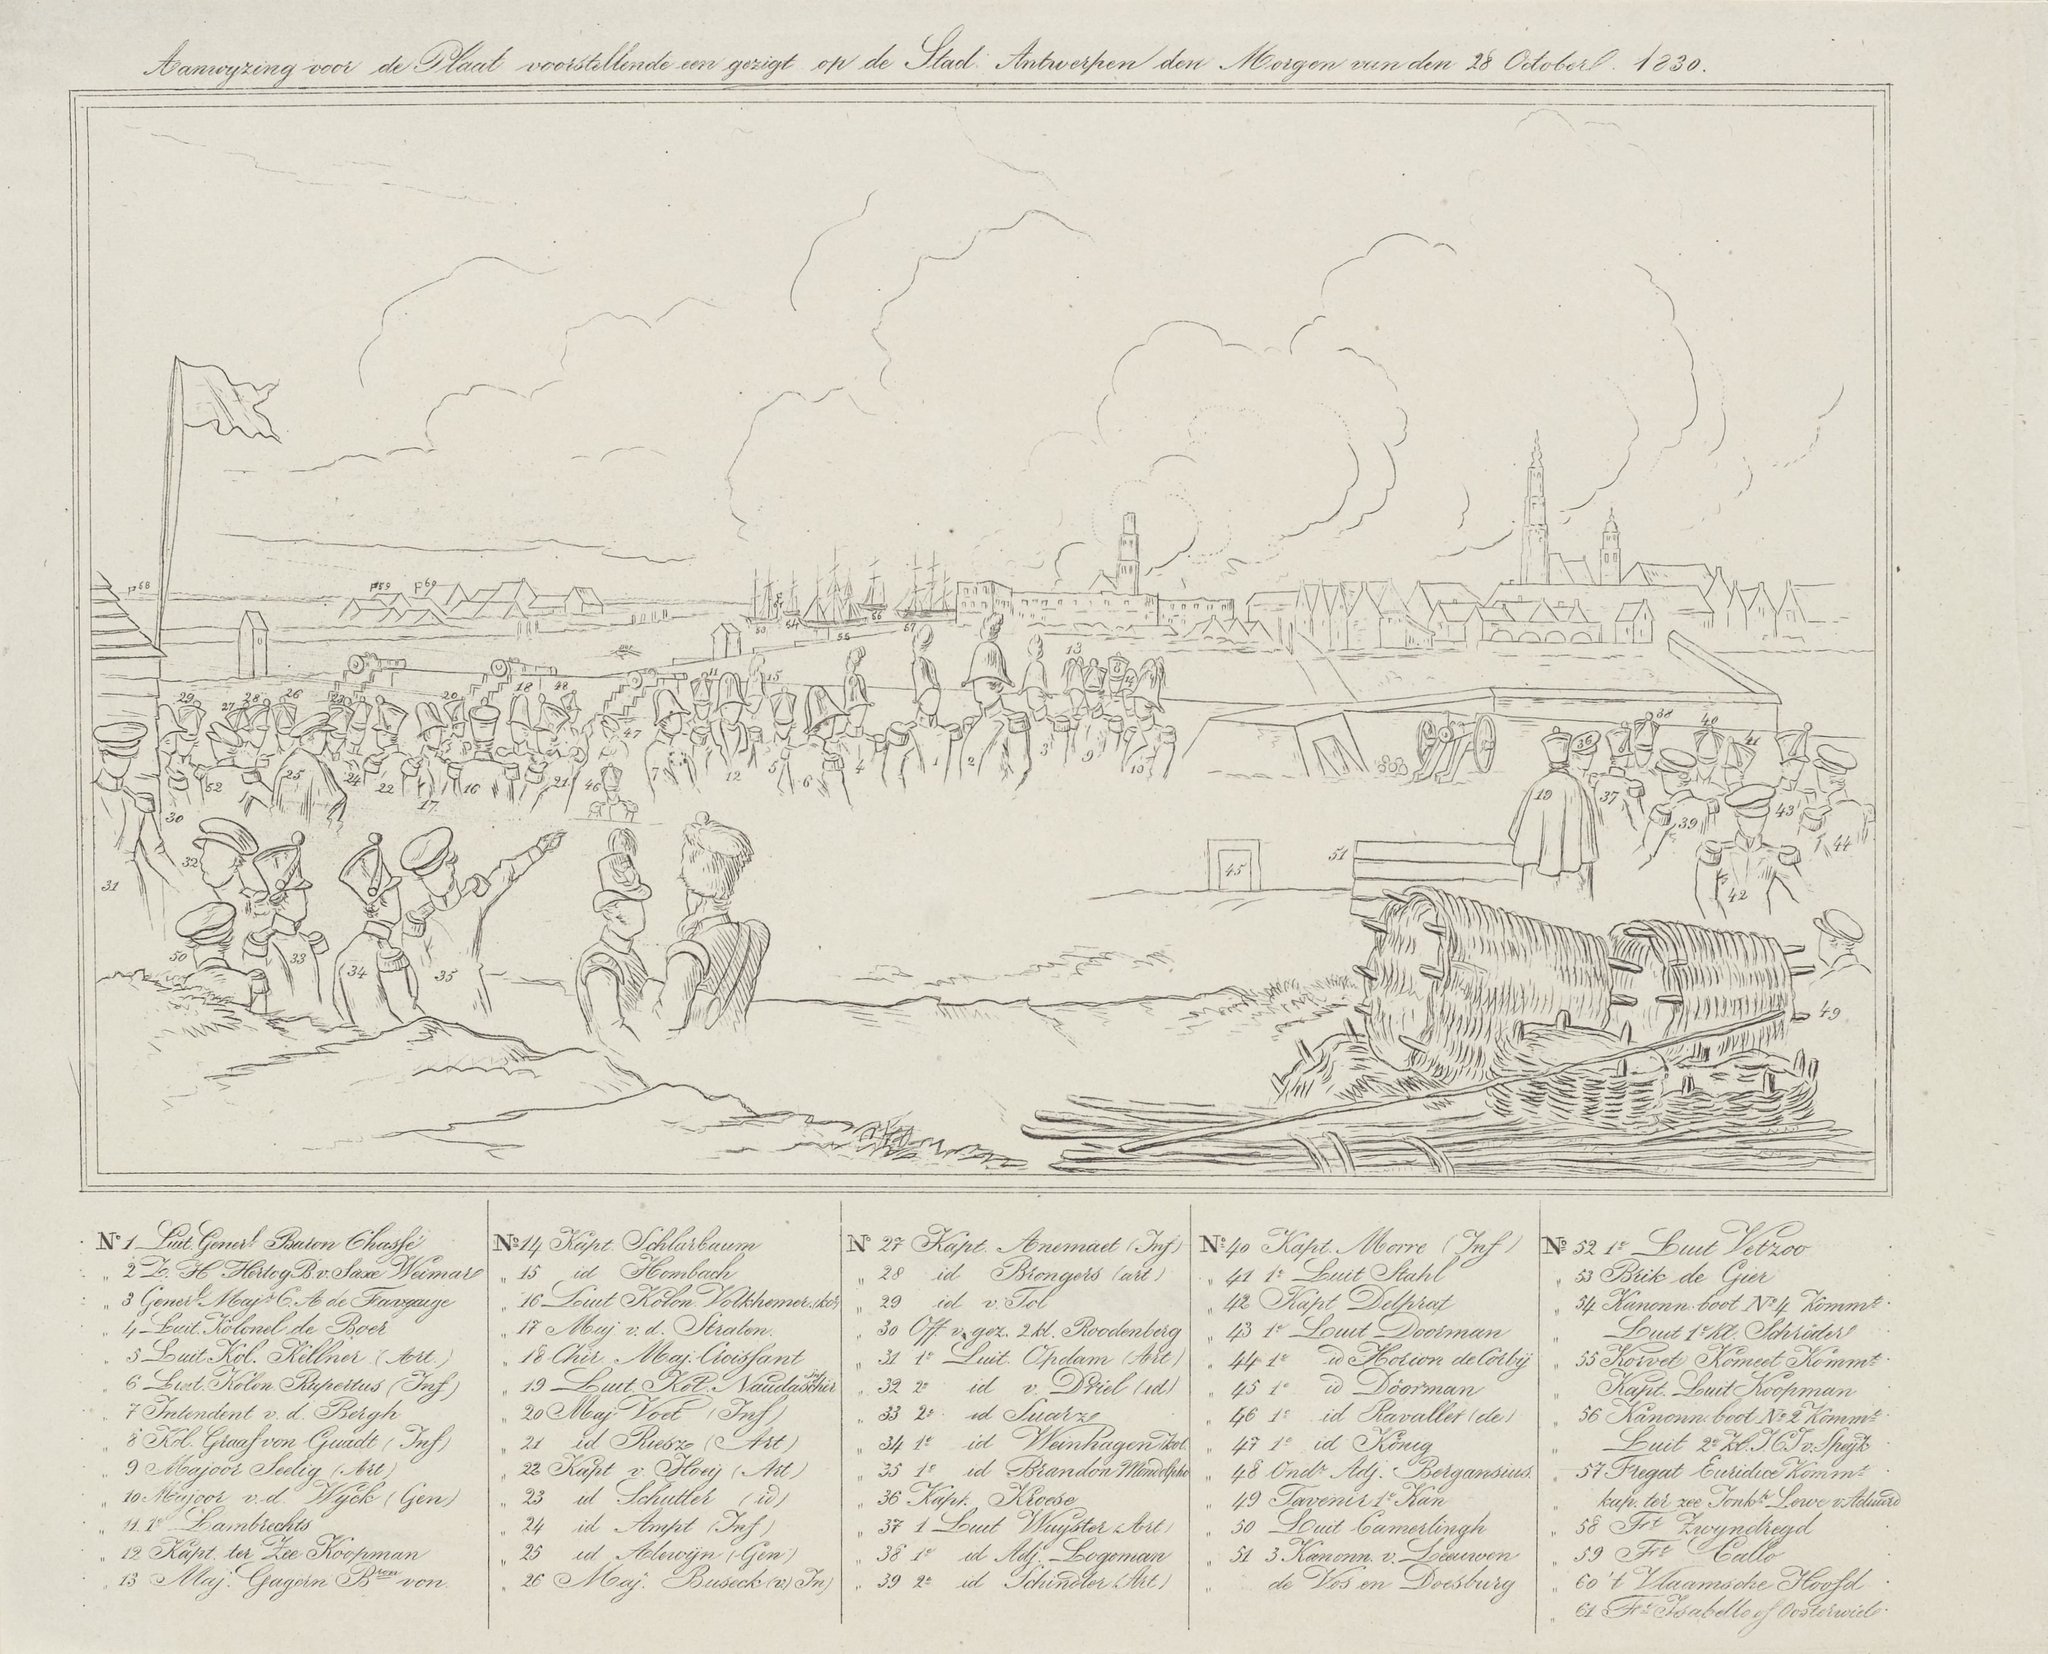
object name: print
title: Aanwijzing voor de Plaat voorstellende een gezigt op de Stad Antwerpen den Morgen van den 28 October 1830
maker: Anonymous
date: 1832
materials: paper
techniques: lithograph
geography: netherlands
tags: david hendrik baron chassé, karel bernhard (hertog van saksen-weimar-eisenach), fortress, antwerp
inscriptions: collector's mark: Lugt 2228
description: Sleutel bij de prent van generaal Chassé omringd door de leden van de Raad van Defensie der Citadel, staande in de Citadel van Antwerpen, op 28 oktober 1830 daags na het bombardement van de stad. Voorstelling in contouren met onderaan in vijf kolommen de namen 1-61.